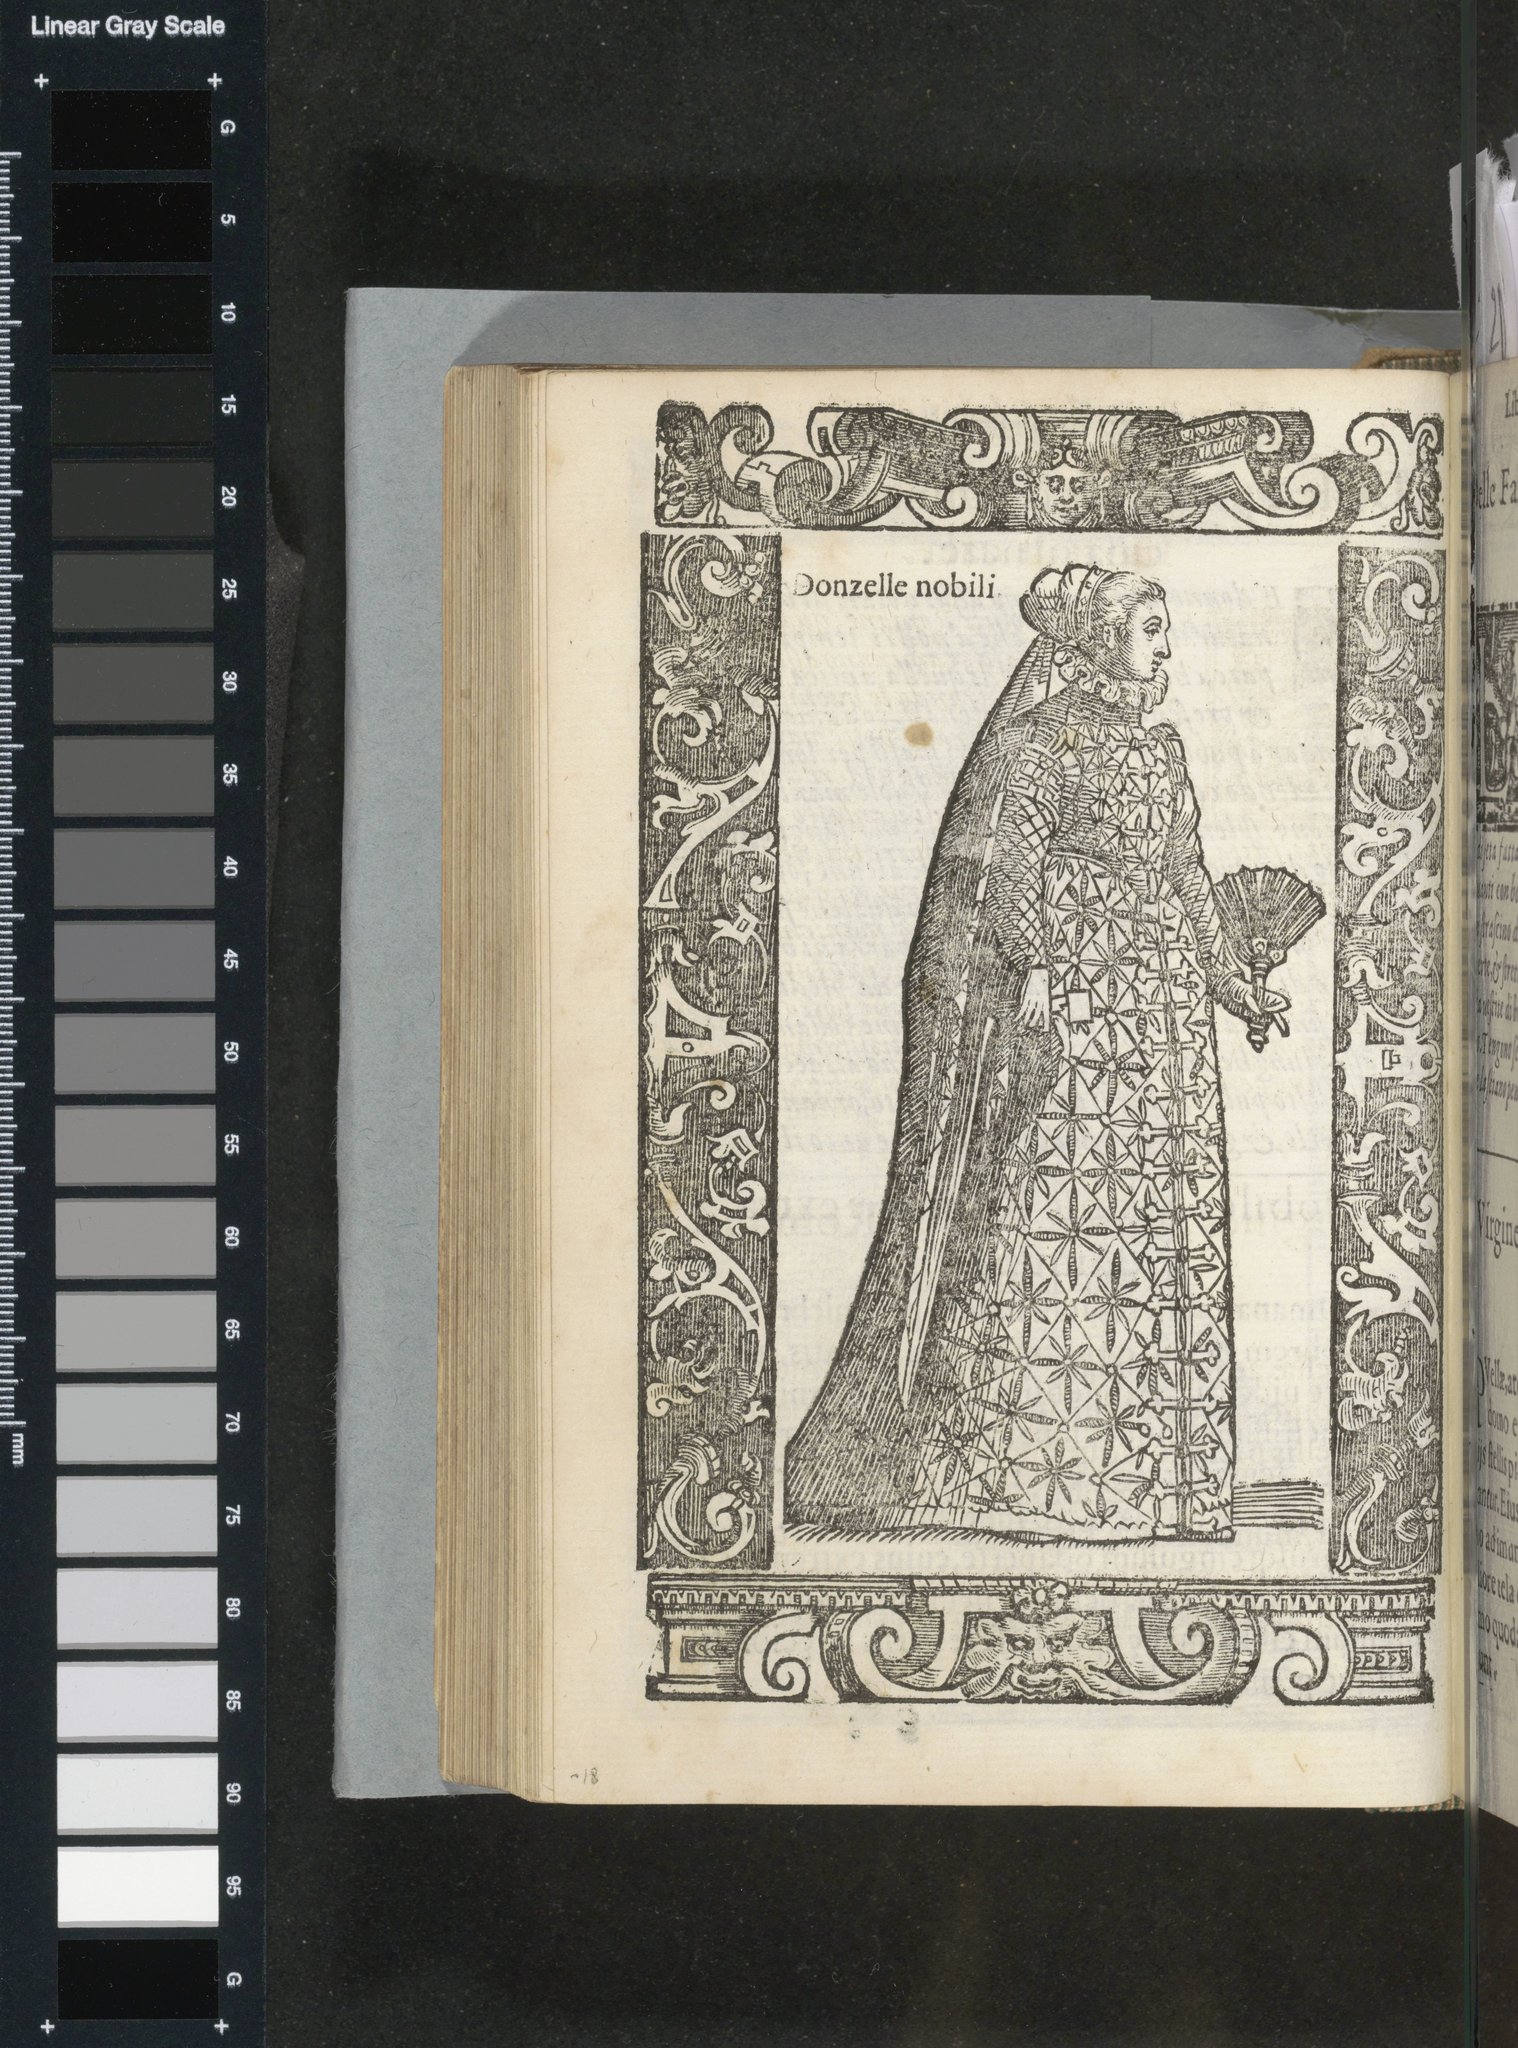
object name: costume print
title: Adellijk meisje uit Rome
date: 1598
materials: paper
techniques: woodcut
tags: veil (+ women's clothes), gloves, mittens (short gloves) (+ women's clothes), head-gear: cap (+ women's clothes), fashion plates, neck-gear ~ clothing (with name) (+ women's clothes), dress, gown (+ women's clothes), fan (+ women's clothes), clothing for the upper part of the body (with name) (+ women's clothes)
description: Volgens de tekst van Vecellio dragen adellijke jongedames, als zij zich buitenshuis begeven (iets wat zij zelden doen), een overkleed van damast of zijden brokaat, versierd met sterren of andere motieven. Het overkleed met lange strakke mouwen is van boven tot onder dichtgeknoopt met gouden knopen. Het haar is opgestoken onder een dunne sluier die op de rug hangt. Waaier in de hand. In ornamentrand.